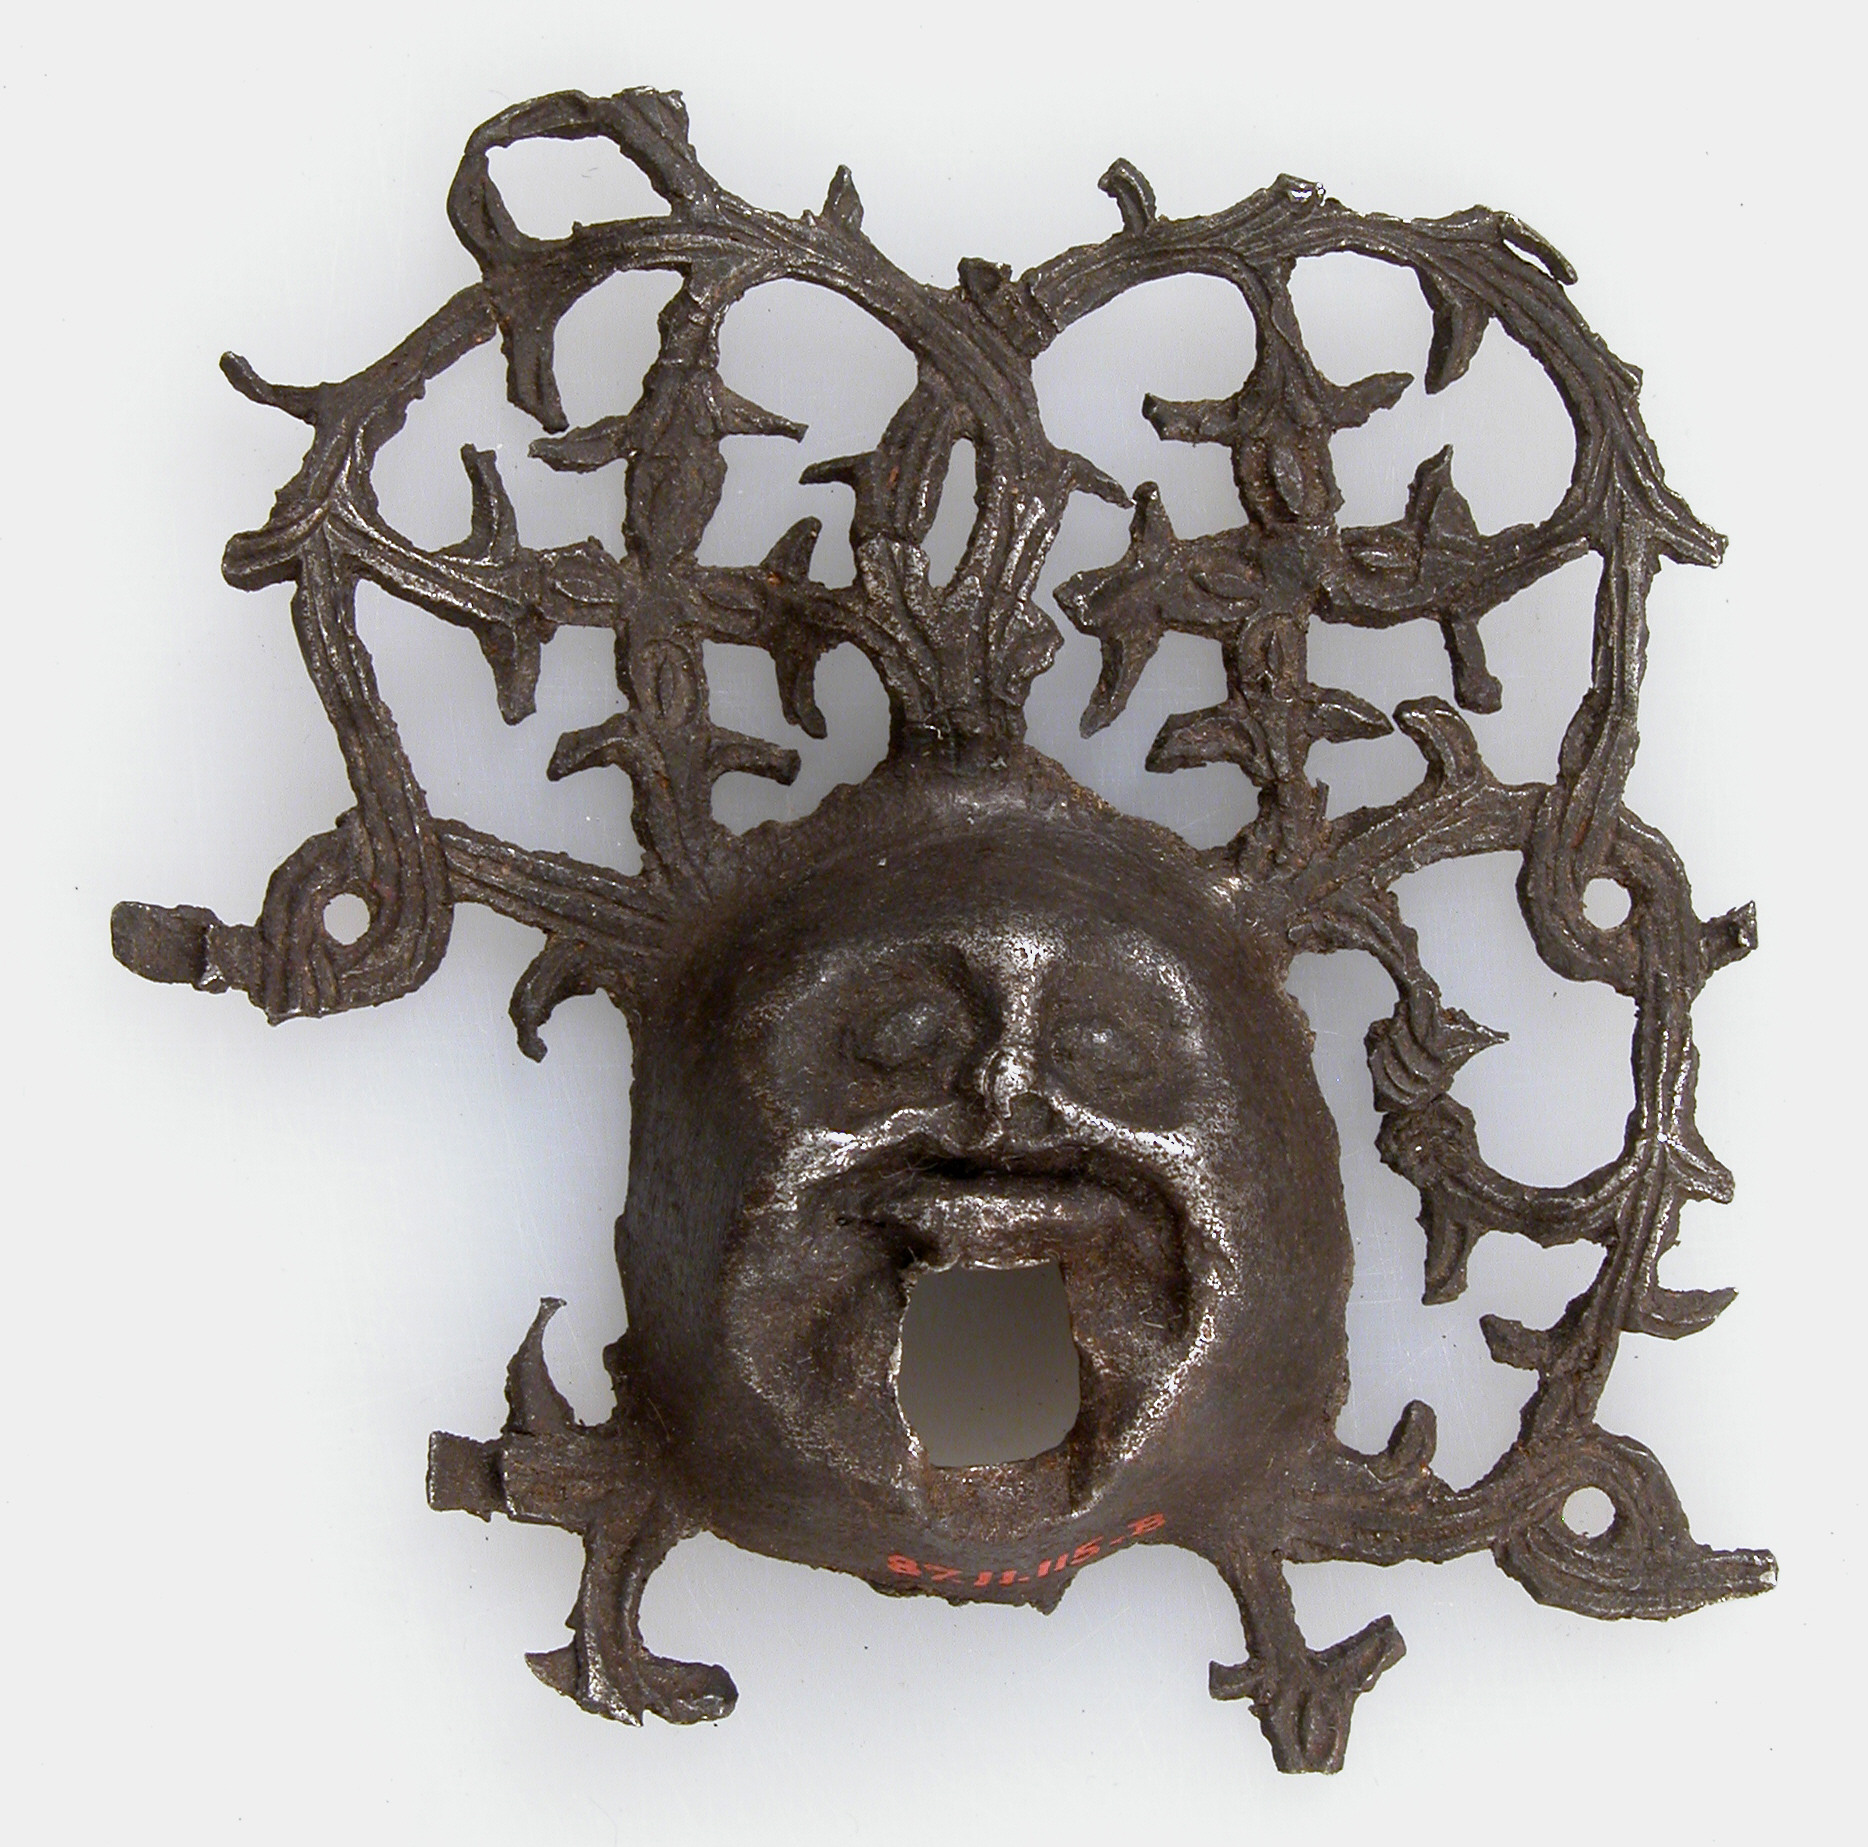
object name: escutcheon plate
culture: german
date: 1401-1500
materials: iron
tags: faces